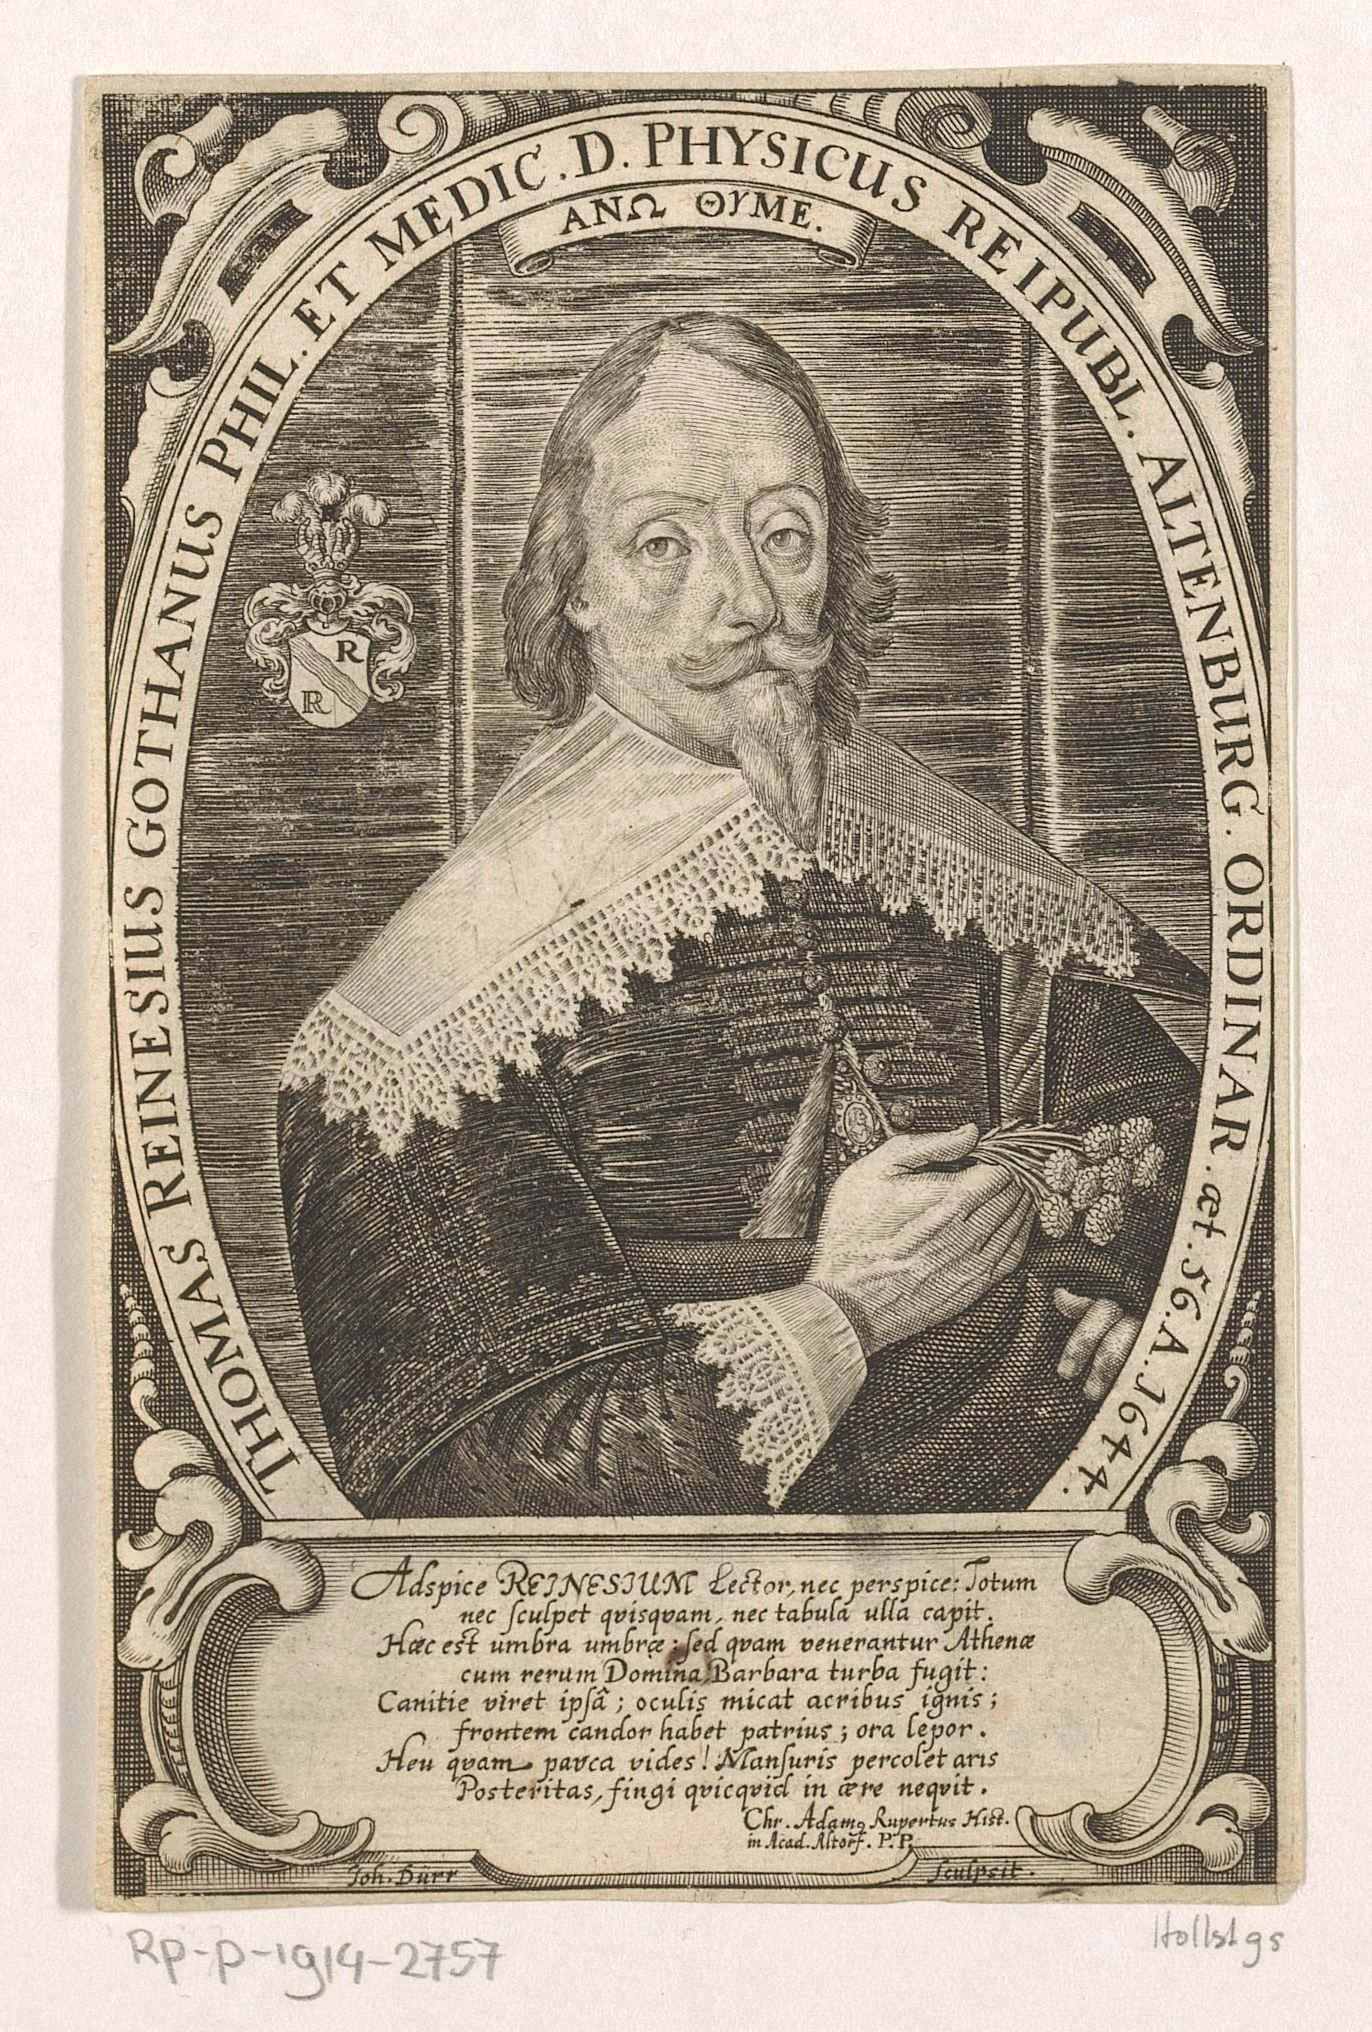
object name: print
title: Portret van Thomas Reinesius op 56-jarige leeftijd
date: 1644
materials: paper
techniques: engraving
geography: berlin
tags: flowers, ornament ~ medallion, historical persons, pendant, trinket, 'breloque', ornament ~ cartouche, armorial bearing, heraldry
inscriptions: collector's mark: Lugt 2228